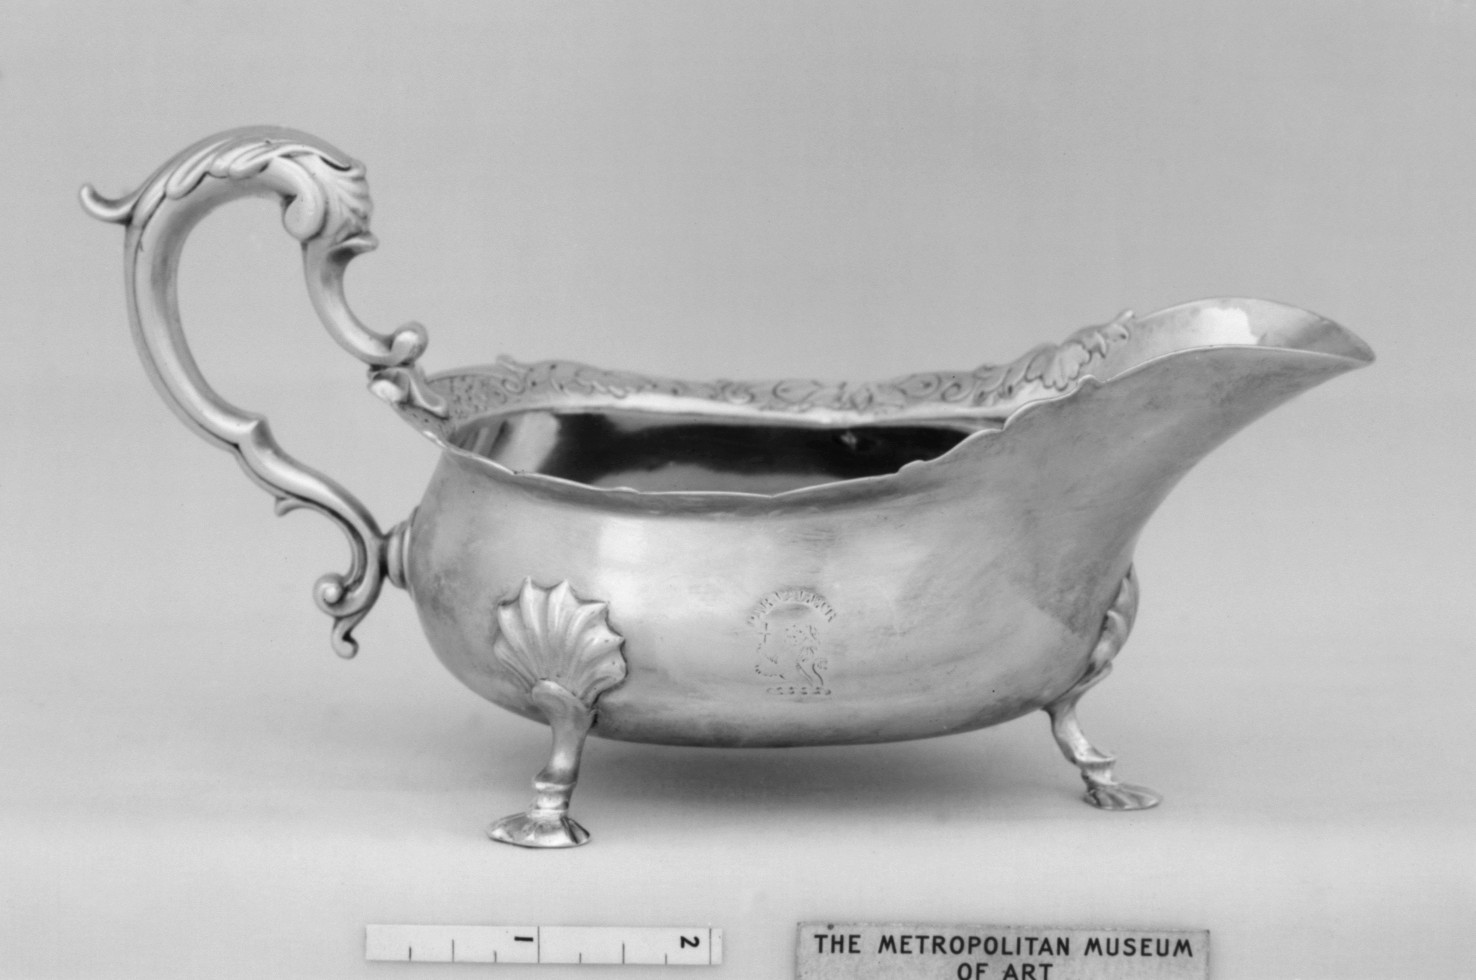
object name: sauceboat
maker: robert lowe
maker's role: maker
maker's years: 1742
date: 1753-1754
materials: silver